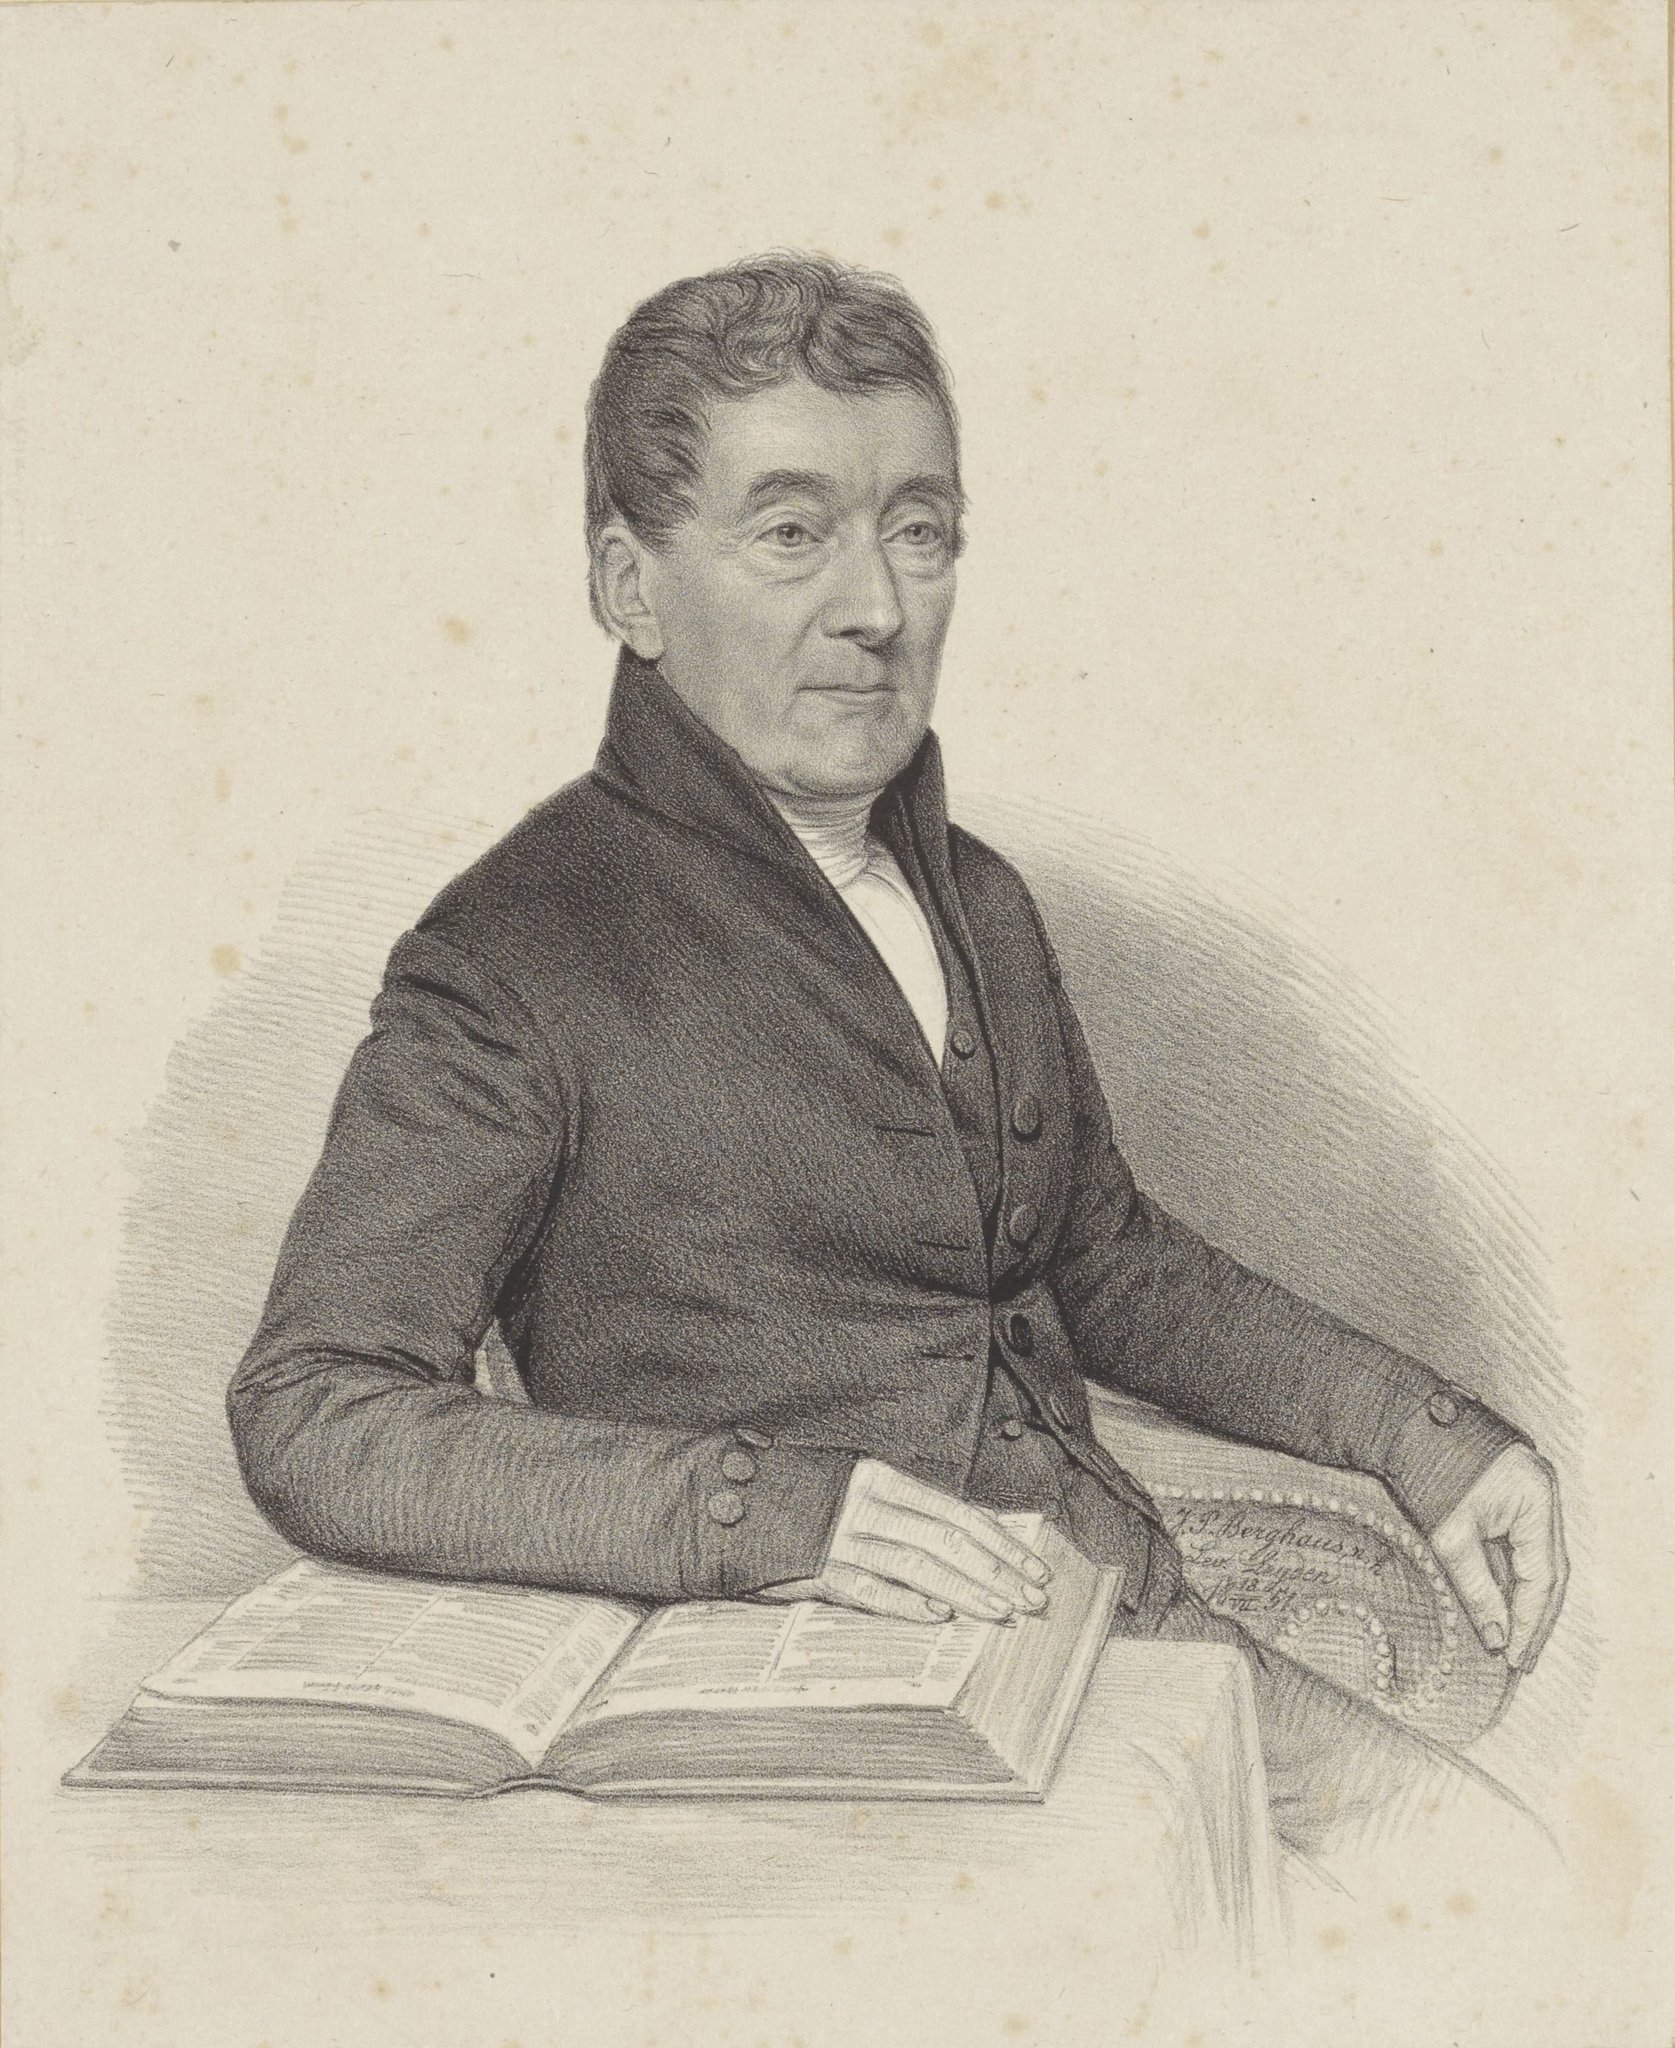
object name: print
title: Portret van een onbekende man, mogelijk de heer Jorissen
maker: johann peter berghaus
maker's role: print maker, printer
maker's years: 1810-1870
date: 1851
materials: paper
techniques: lithograph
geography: leiden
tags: historical persons, book - mm - book open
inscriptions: collector's mark: Lugt 2228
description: De geportretteerde zit gedraaid op een stoel achter een tafel. Zijn linkerarm rust op een opengeslagen boek, zijn rechterarm op de leuning van de stoel.